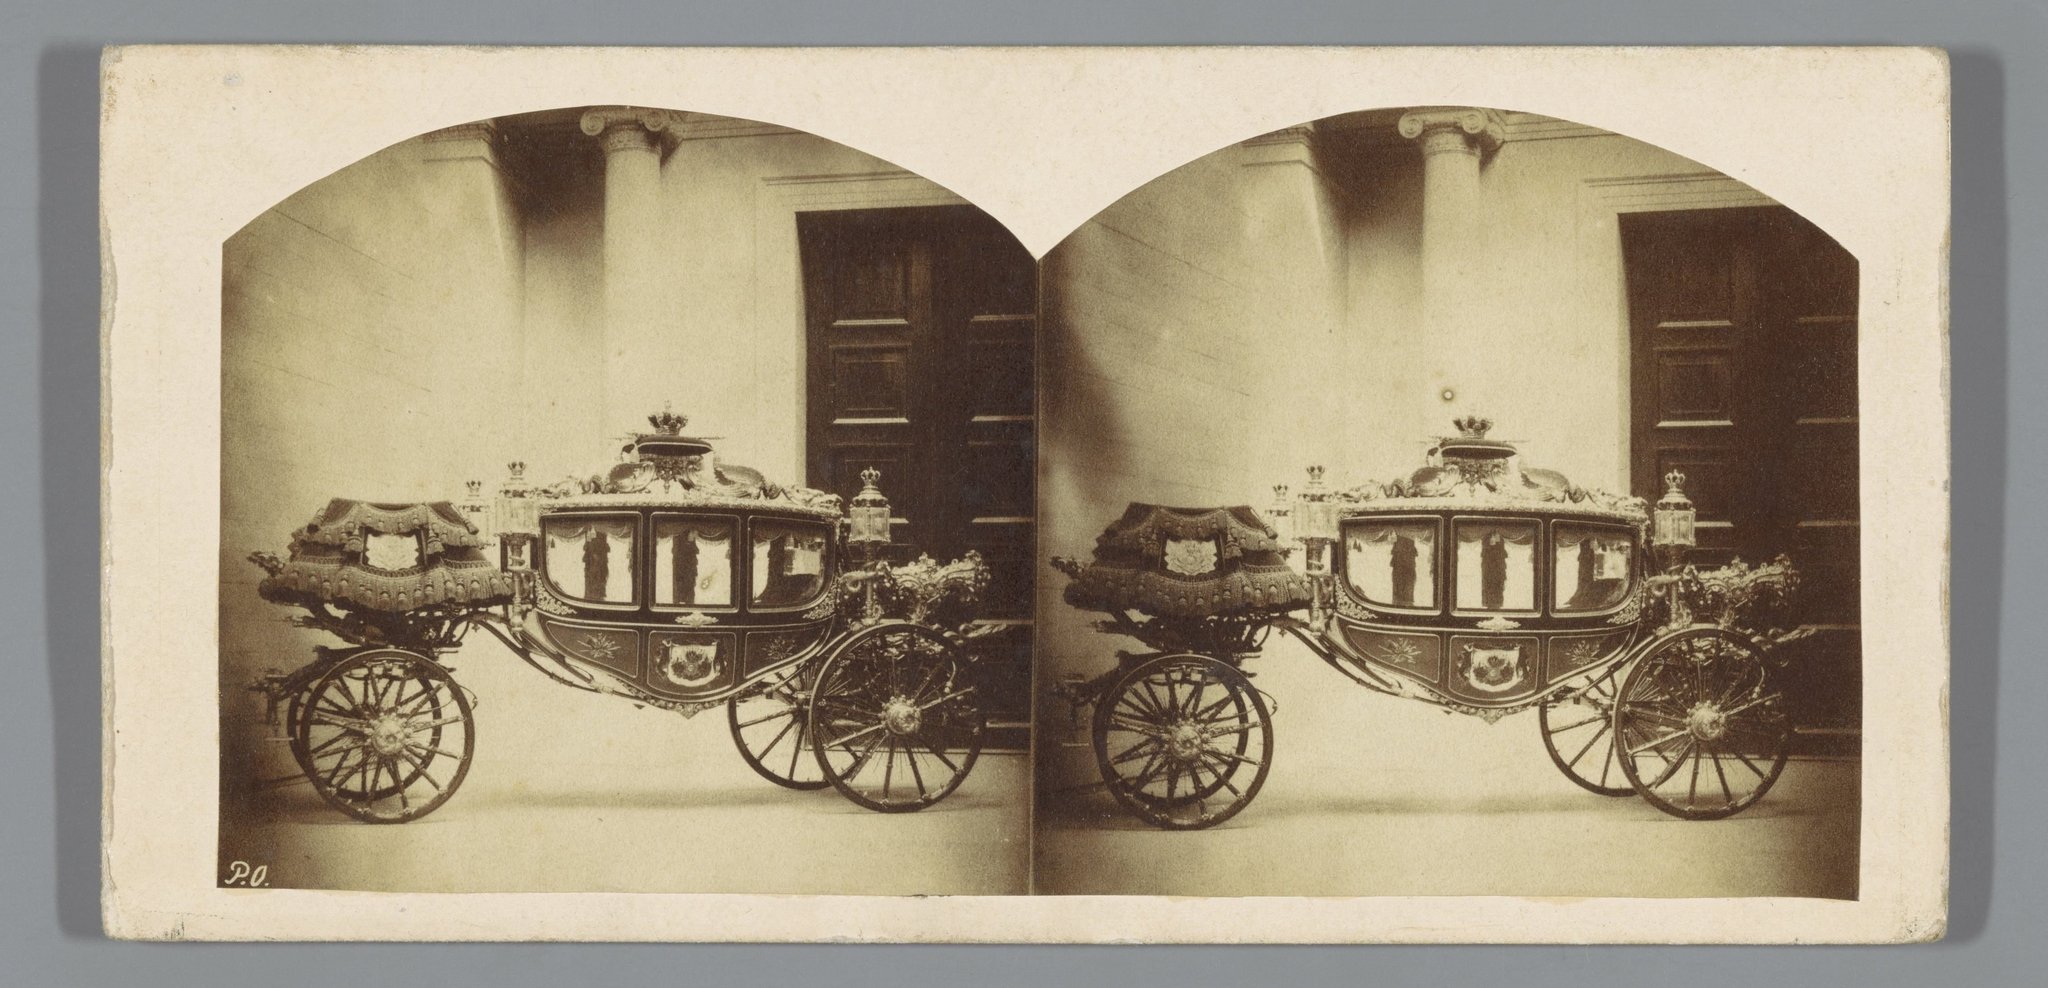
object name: stereograph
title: Staatsiekoets van den Keizer van Solo, vervaardigd in de Fabriek van M.L. Hermans en Co., te 's Gravenhage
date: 1859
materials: cardboard, paper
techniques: albumen print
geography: amsterdam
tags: passenger carriage, the hague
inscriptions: inscription: ‘foto Pieter Oosterhuis’, inscription: ‘Voiture d'apparat/ de/ l'empereur de Solo,/ fait par/ M.L. Hermans et Co.,/ à la Haye.’, inscription: ‘Gephotographieerd in Augustus 1859./ Uitgegeven bij A. Jager,/ Amsterdam, Water 110.’, initials: ‘P.O.’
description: Solo was in de negentiende eeuw een gangbare benaming voor Soerakarta in het Nederlands.